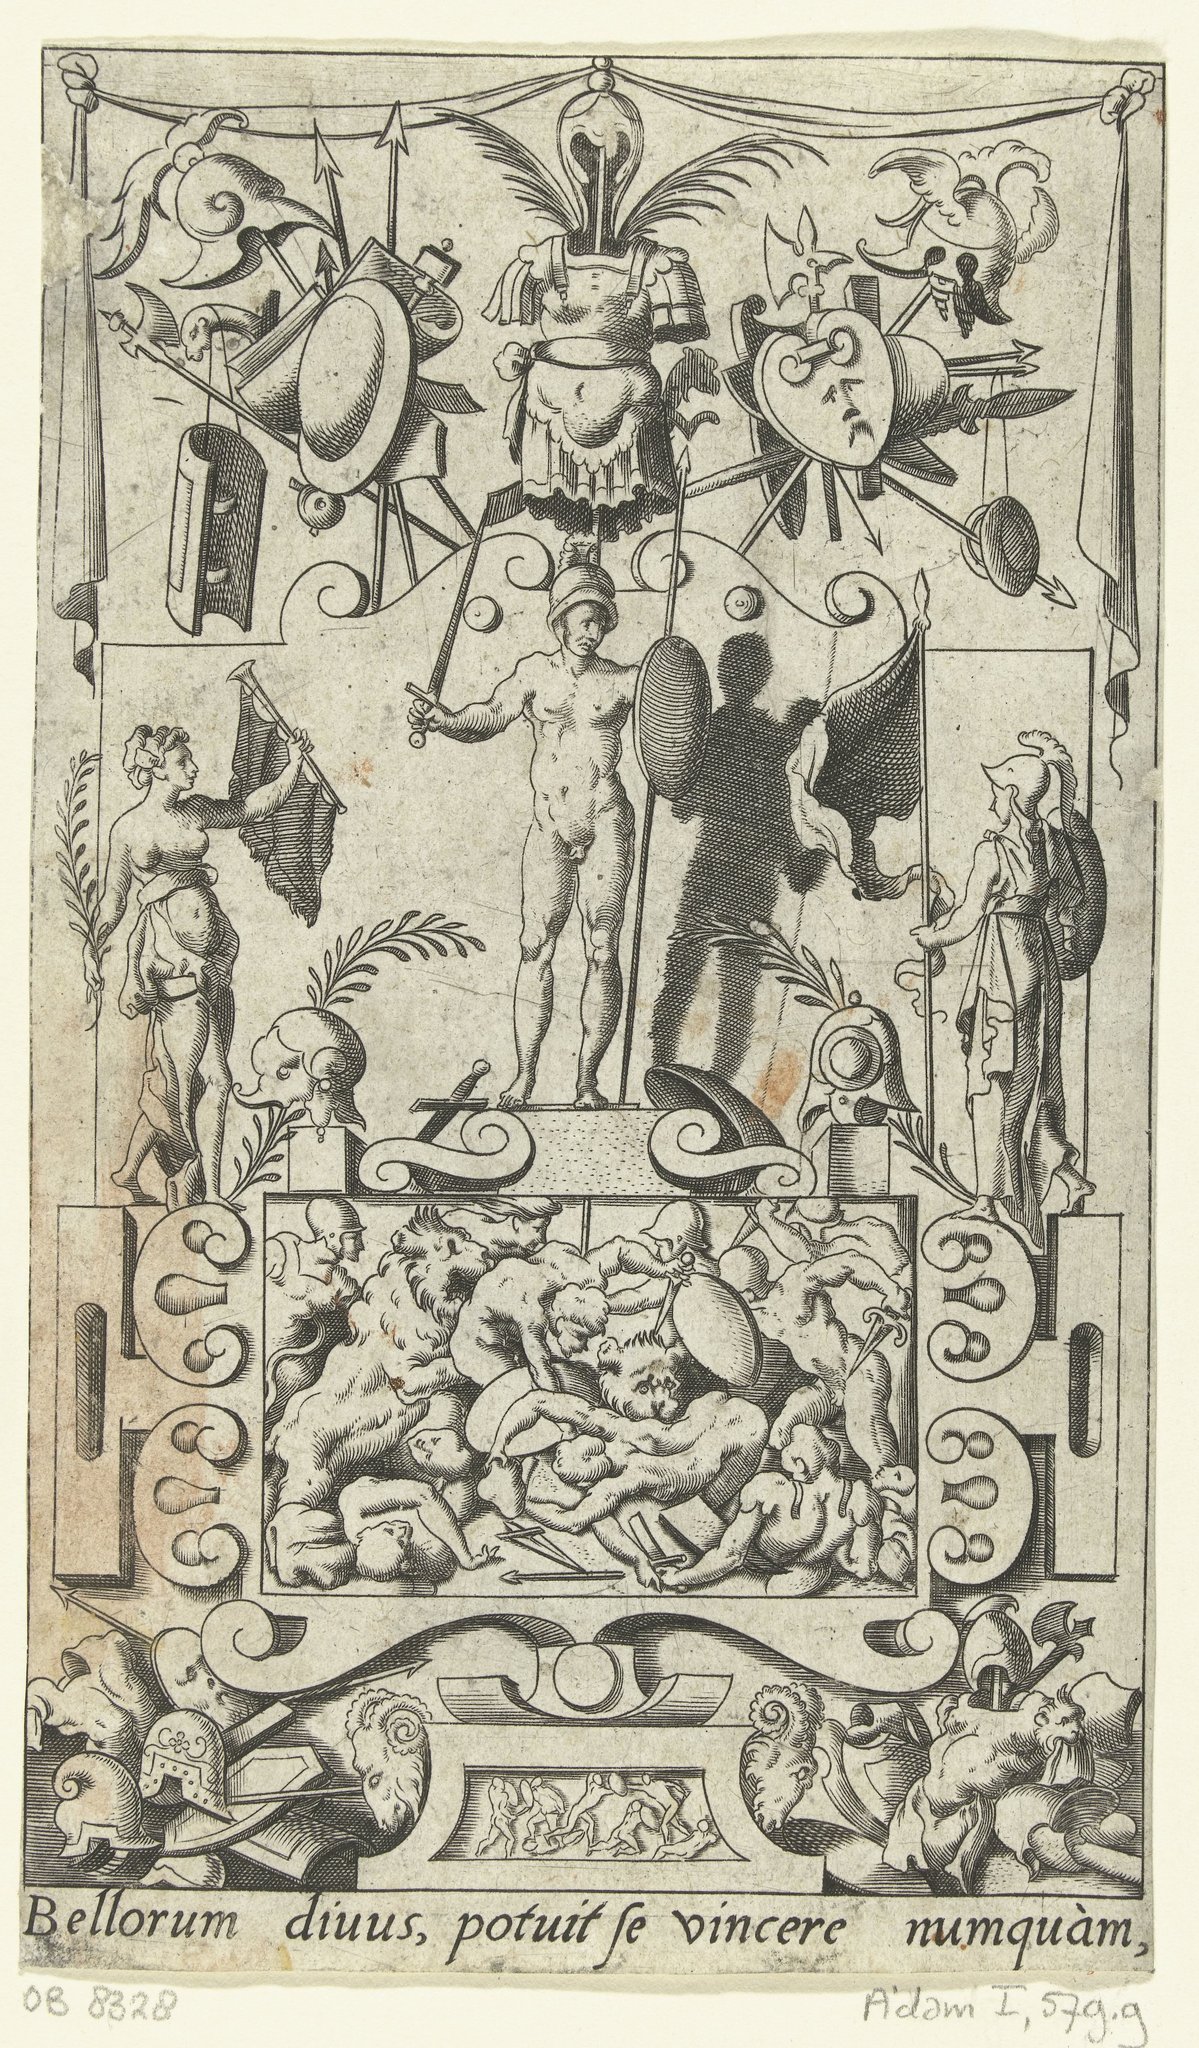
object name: ornament print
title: Goden en godinnen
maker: rené boyvin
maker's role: print maker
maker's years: 1525-1598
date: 1551-1580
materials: paper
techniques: engraving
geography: france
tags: (story of) mars (ares)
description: Onderaan staat een Latijnse tekst. Uit serie van 16 deels genummerde bladen met vlakdecoraties van goden en godinnen in een omlijsting van grotesken met fantastische wezens, dieren, guirlandes en mascarons.